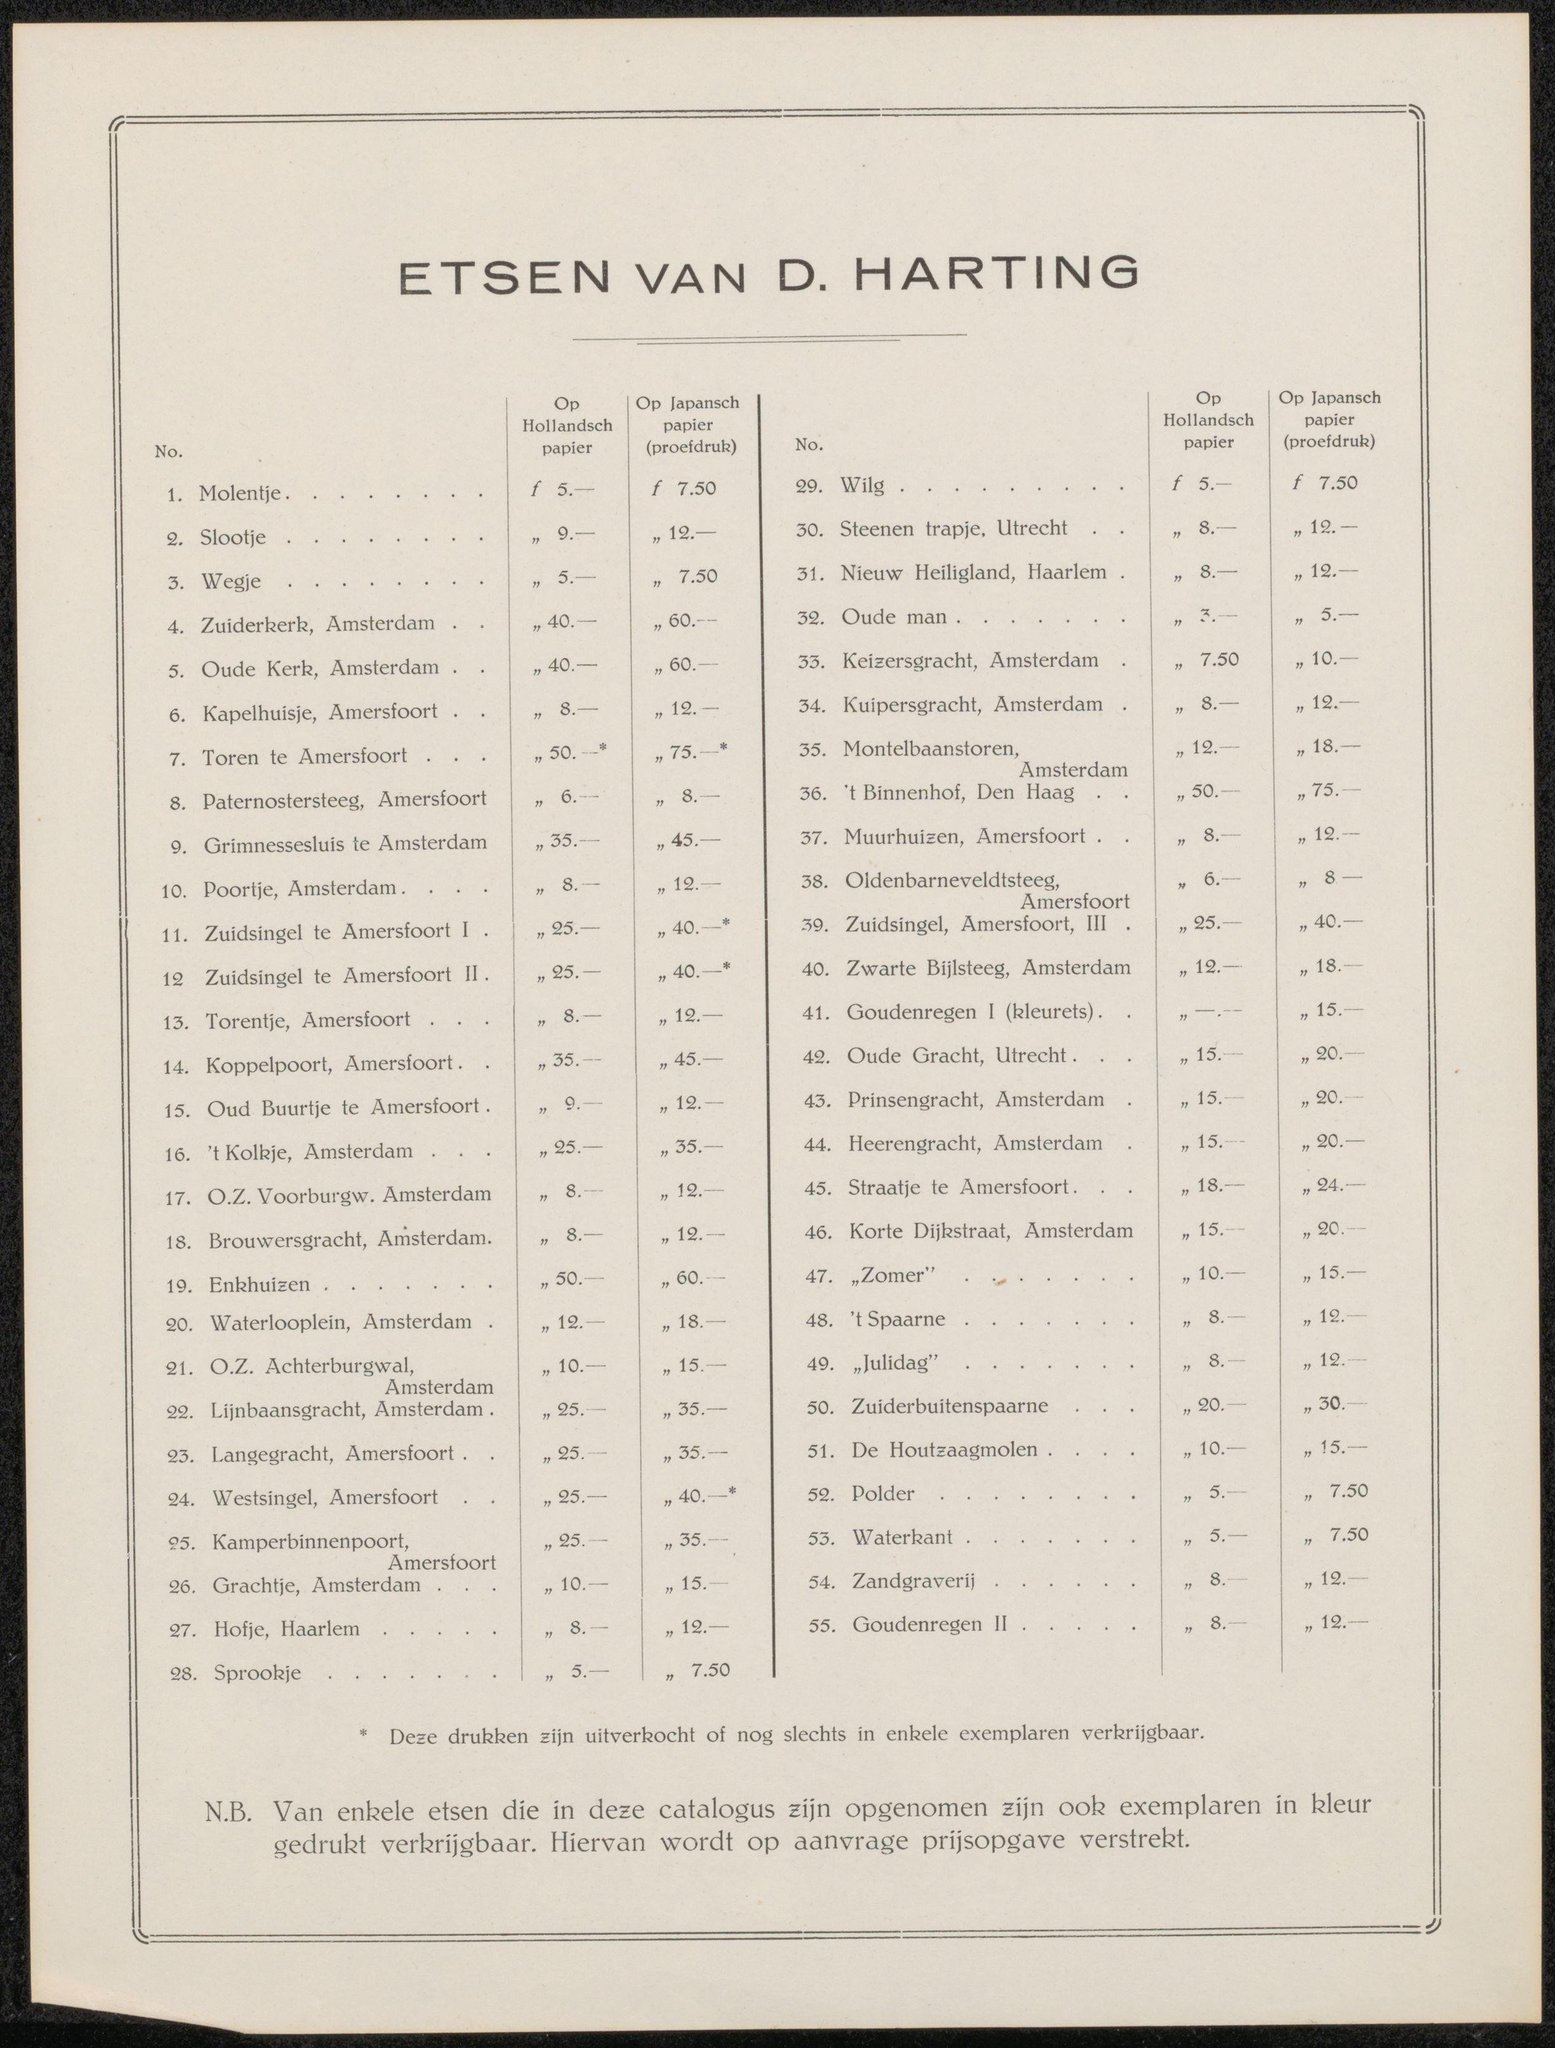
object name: document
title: Lijst van etsen van Dirk Harting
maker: Anonymous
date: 1913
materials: paper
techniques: printing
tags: haarlem, painter, dirk harting, art trade, art shop, the graphic arts, money